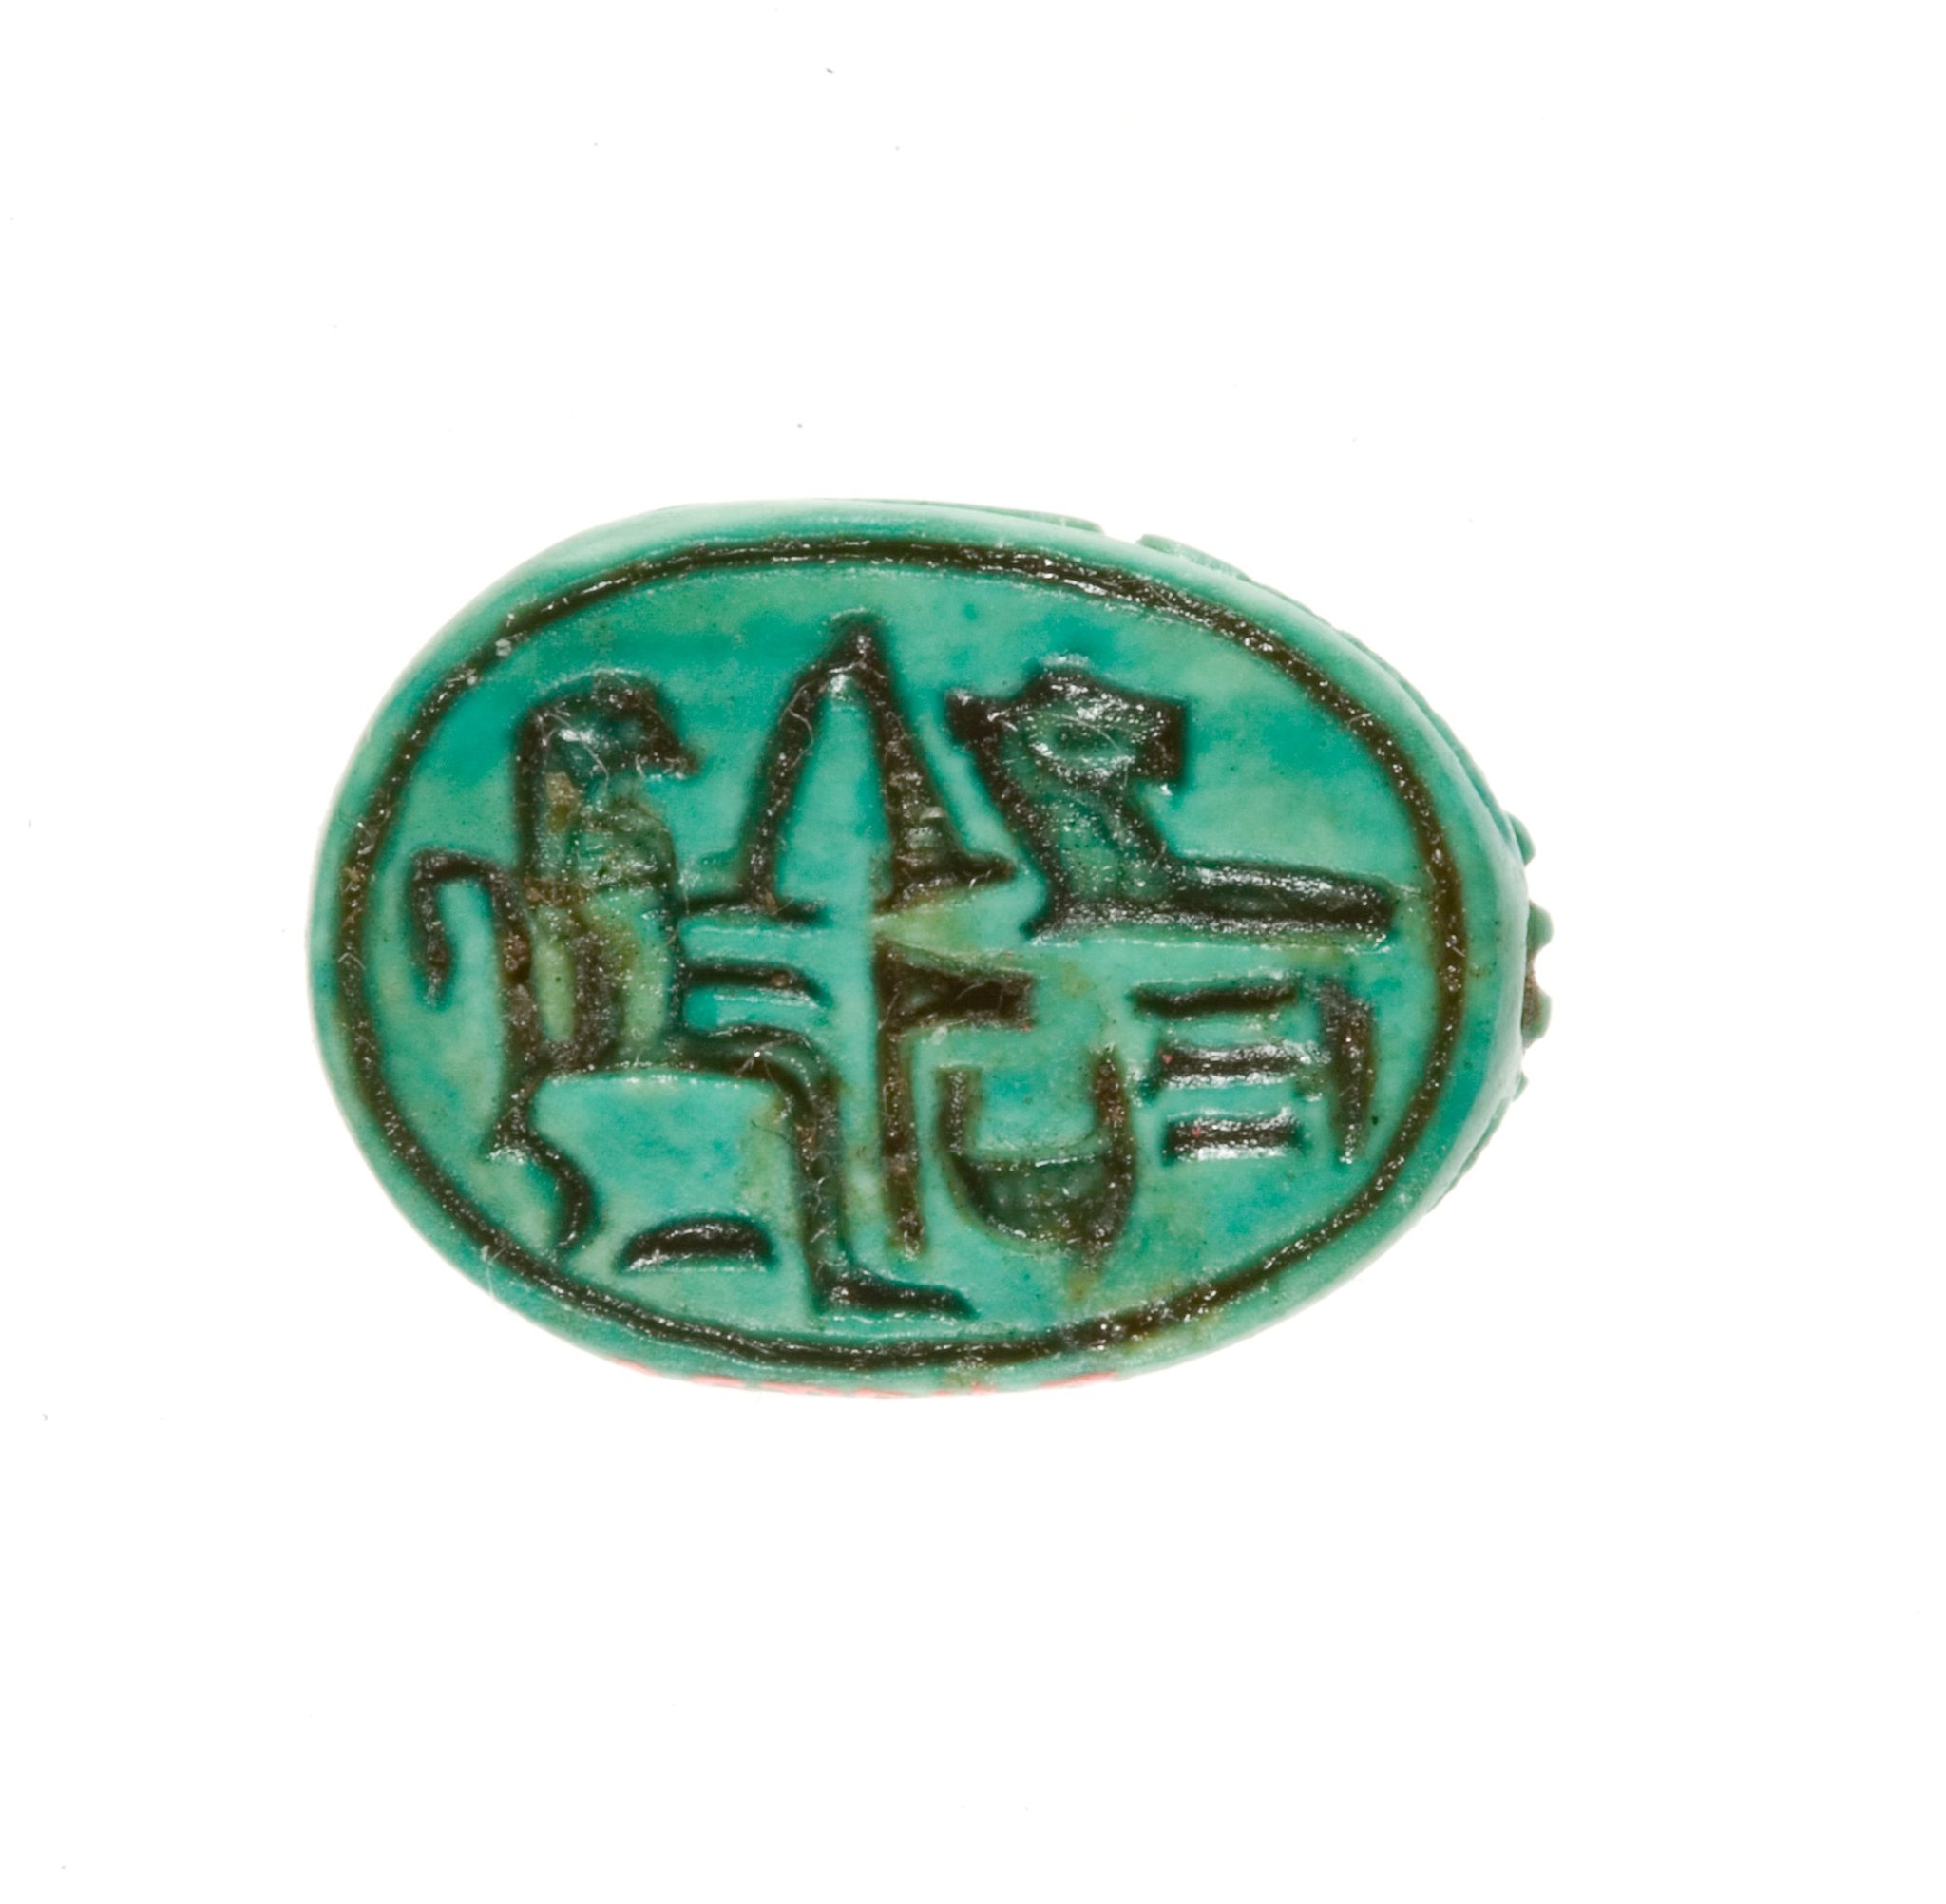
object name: scarab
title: Scarab Inscribed for the God's Wife Hatshepsut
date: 1479-1458 BCE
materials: stone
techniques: glazing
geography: egypt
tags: hieroglyphs,scarabs